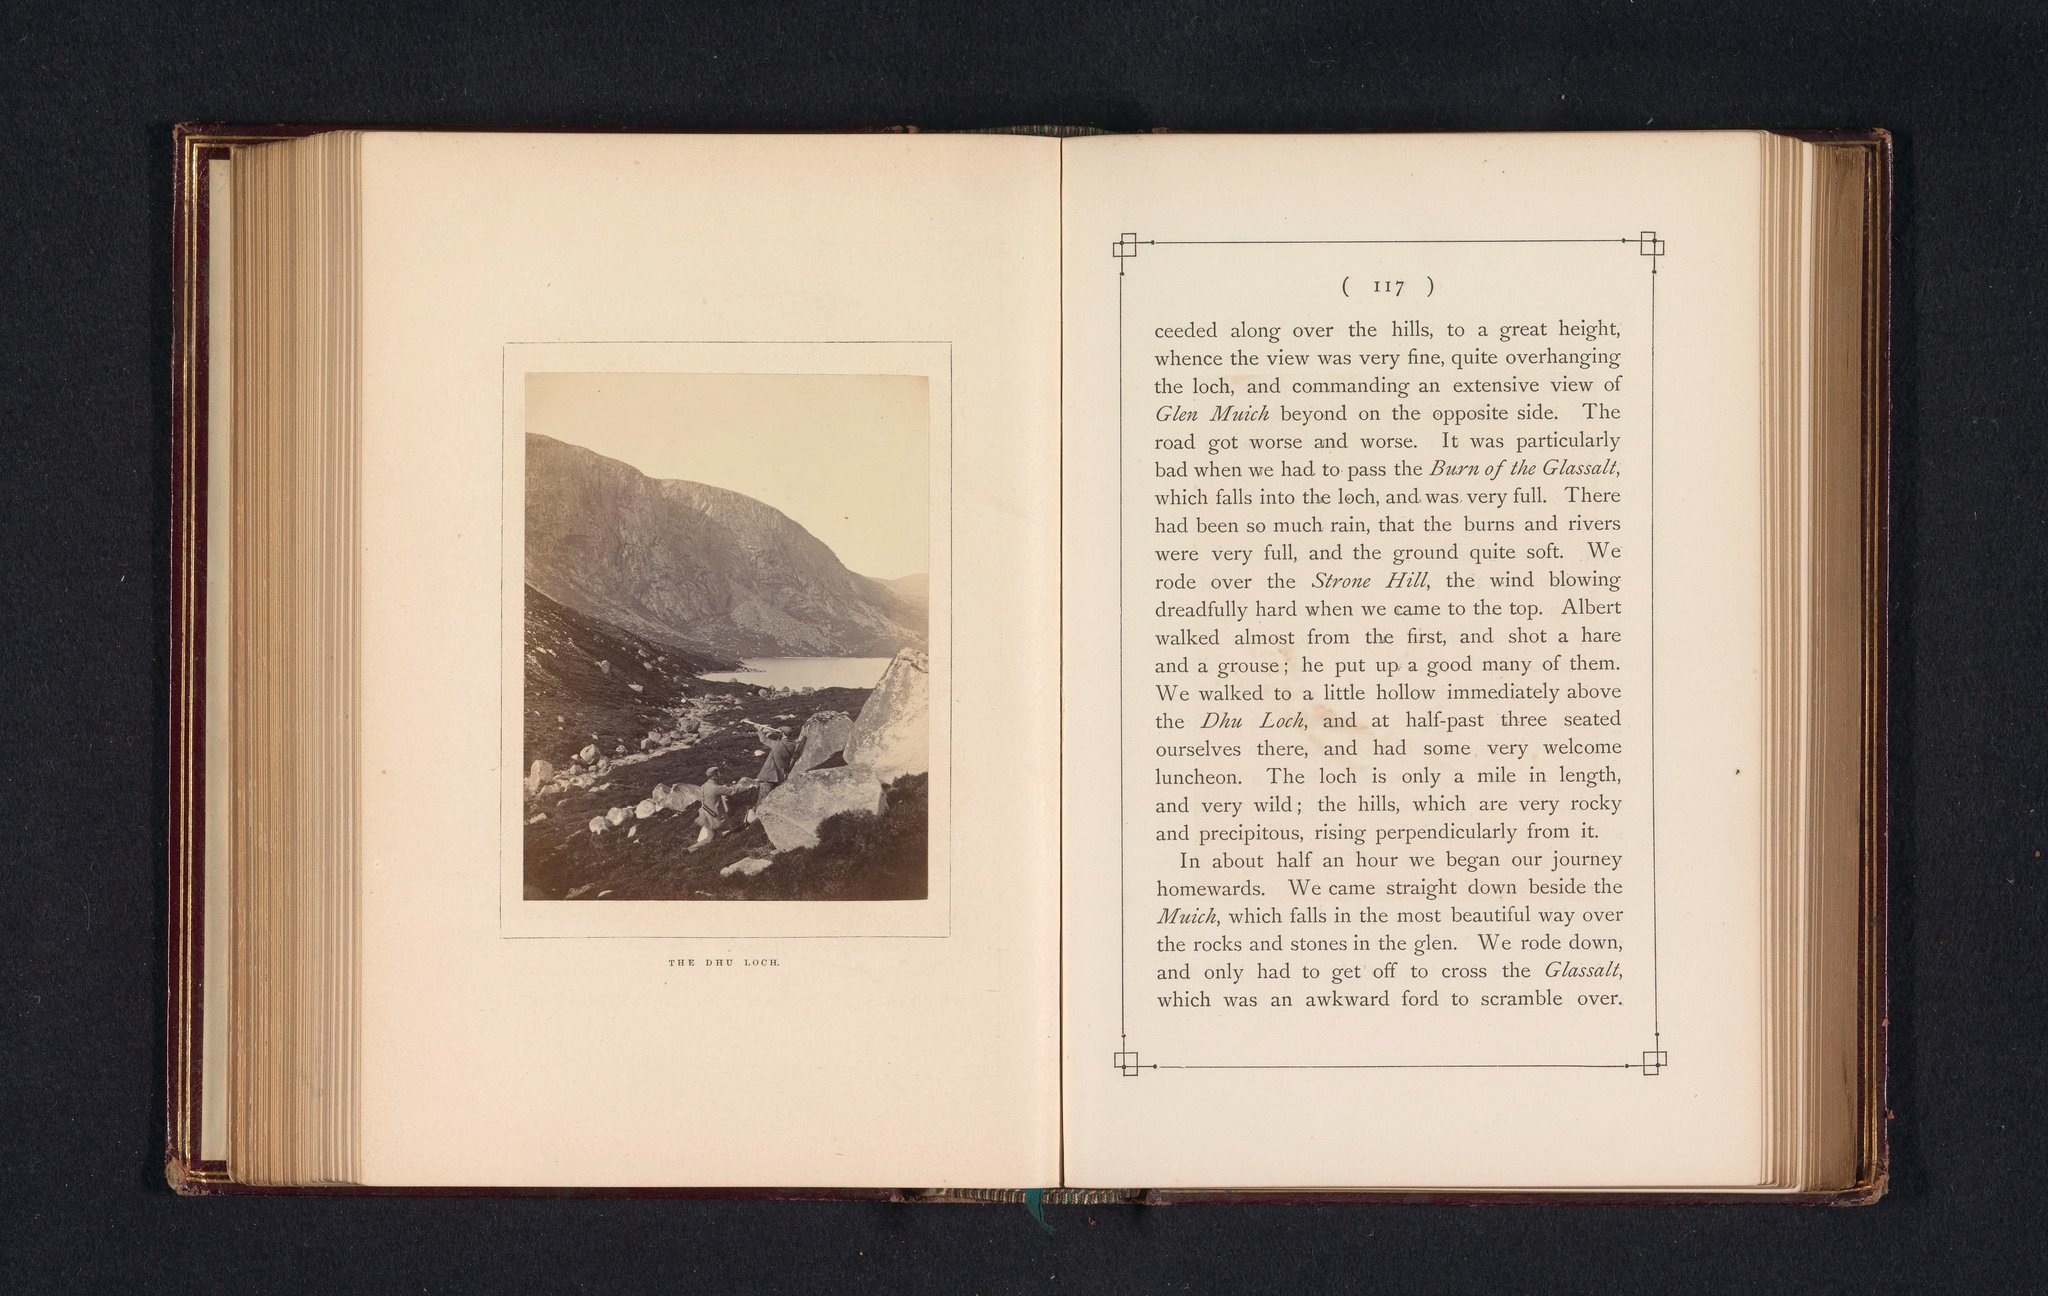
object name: page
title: Gezicht op het Dhu Loch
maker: george washington wilson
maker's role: publisher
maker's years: 1823-1893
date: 1858-1868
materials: photographic support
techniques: albumen print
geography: scotland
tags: lake, mountains